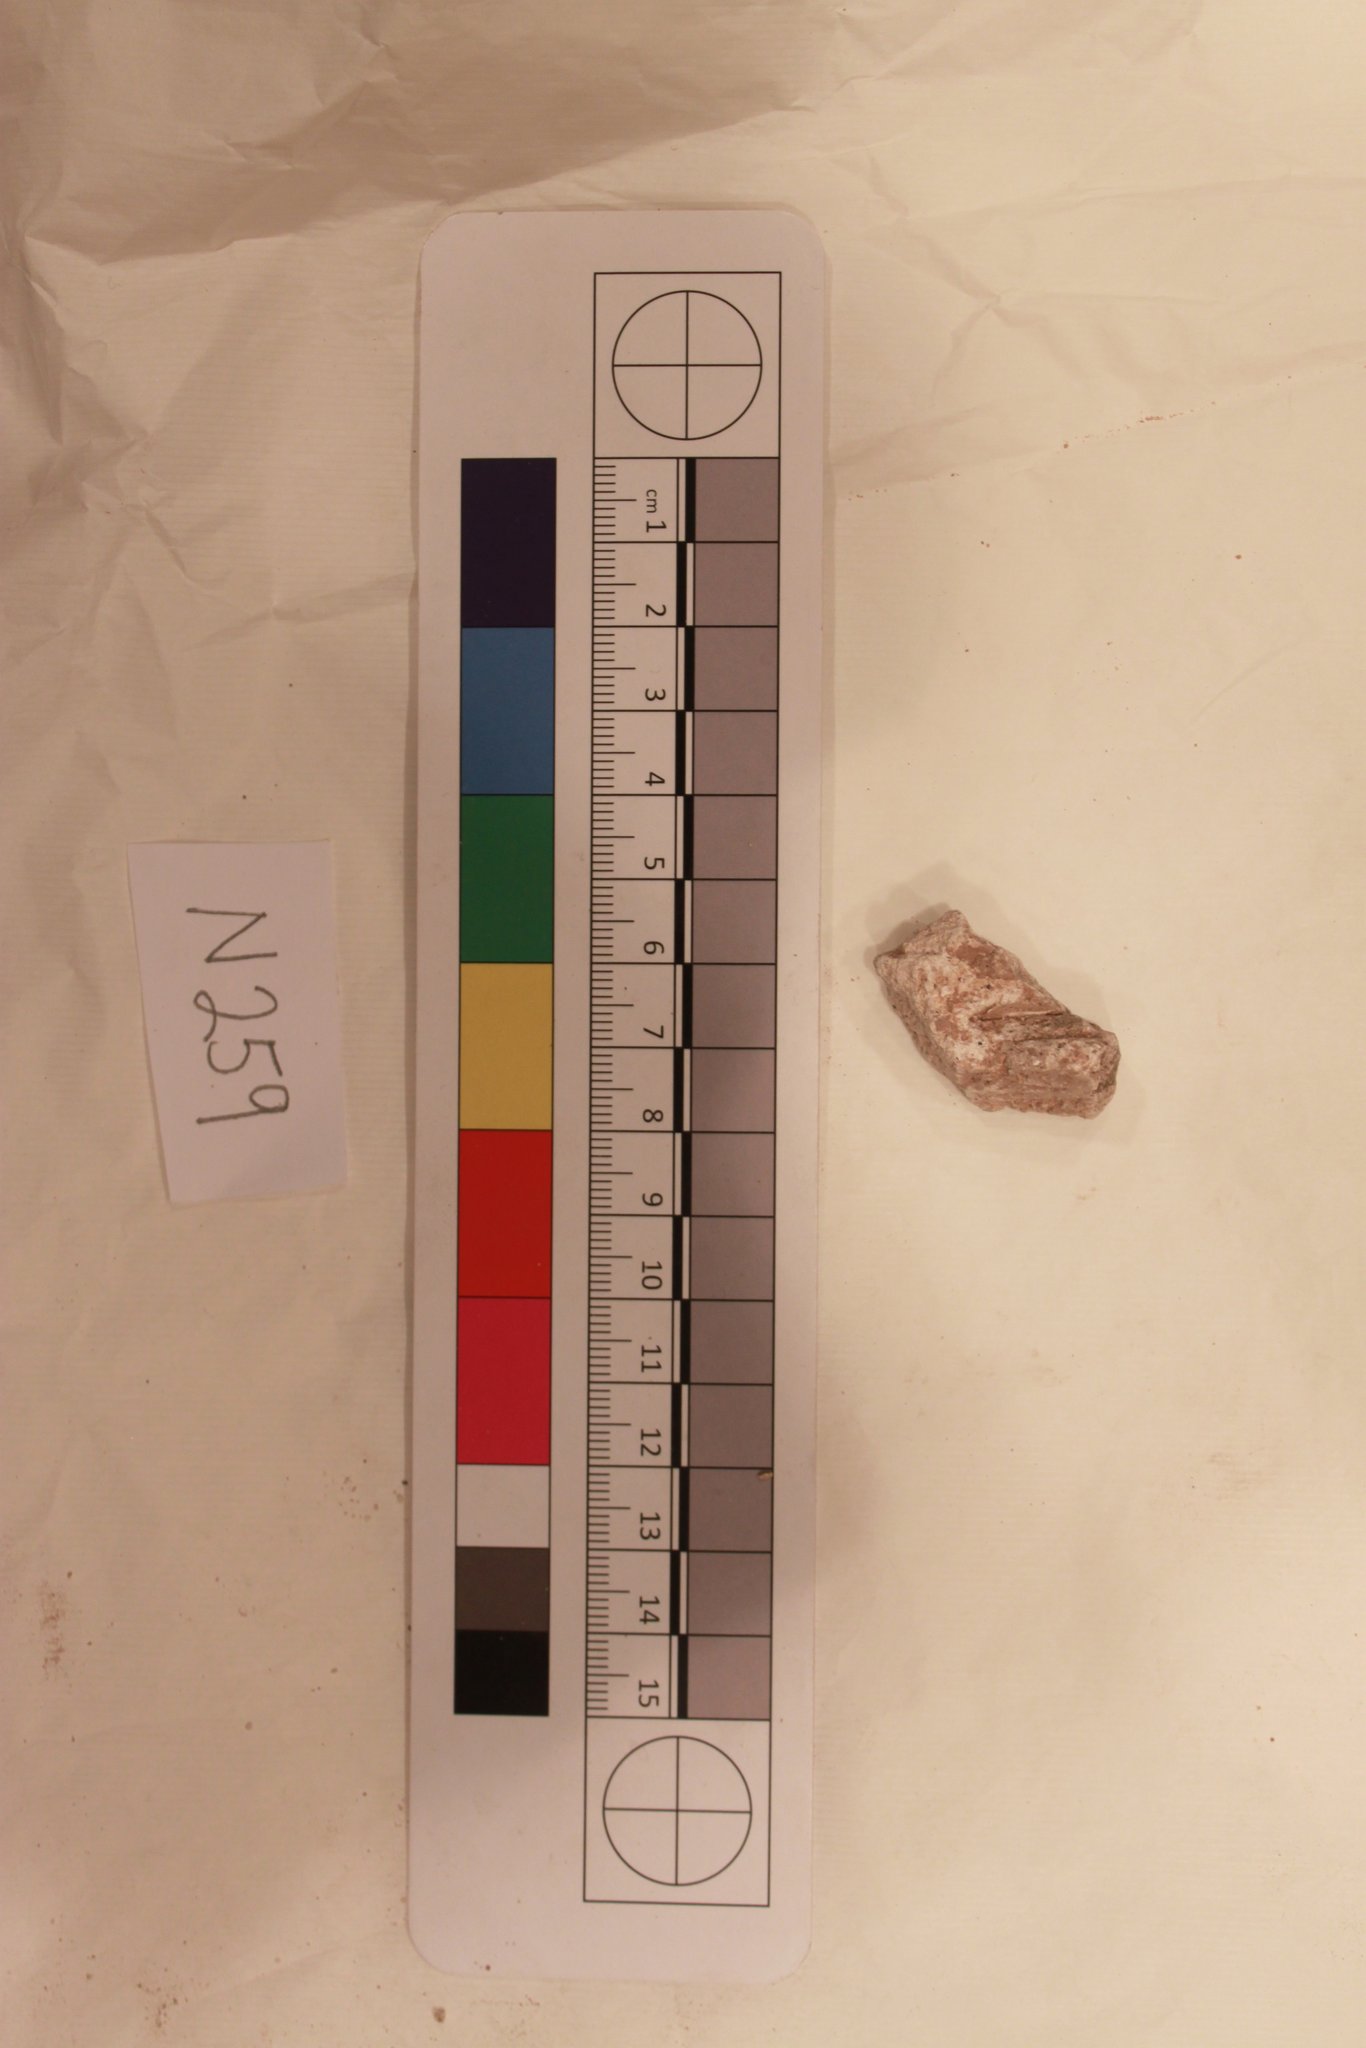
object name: fragment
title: Stucco Fragment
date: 701-1200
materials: plaster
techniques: carving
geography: iran